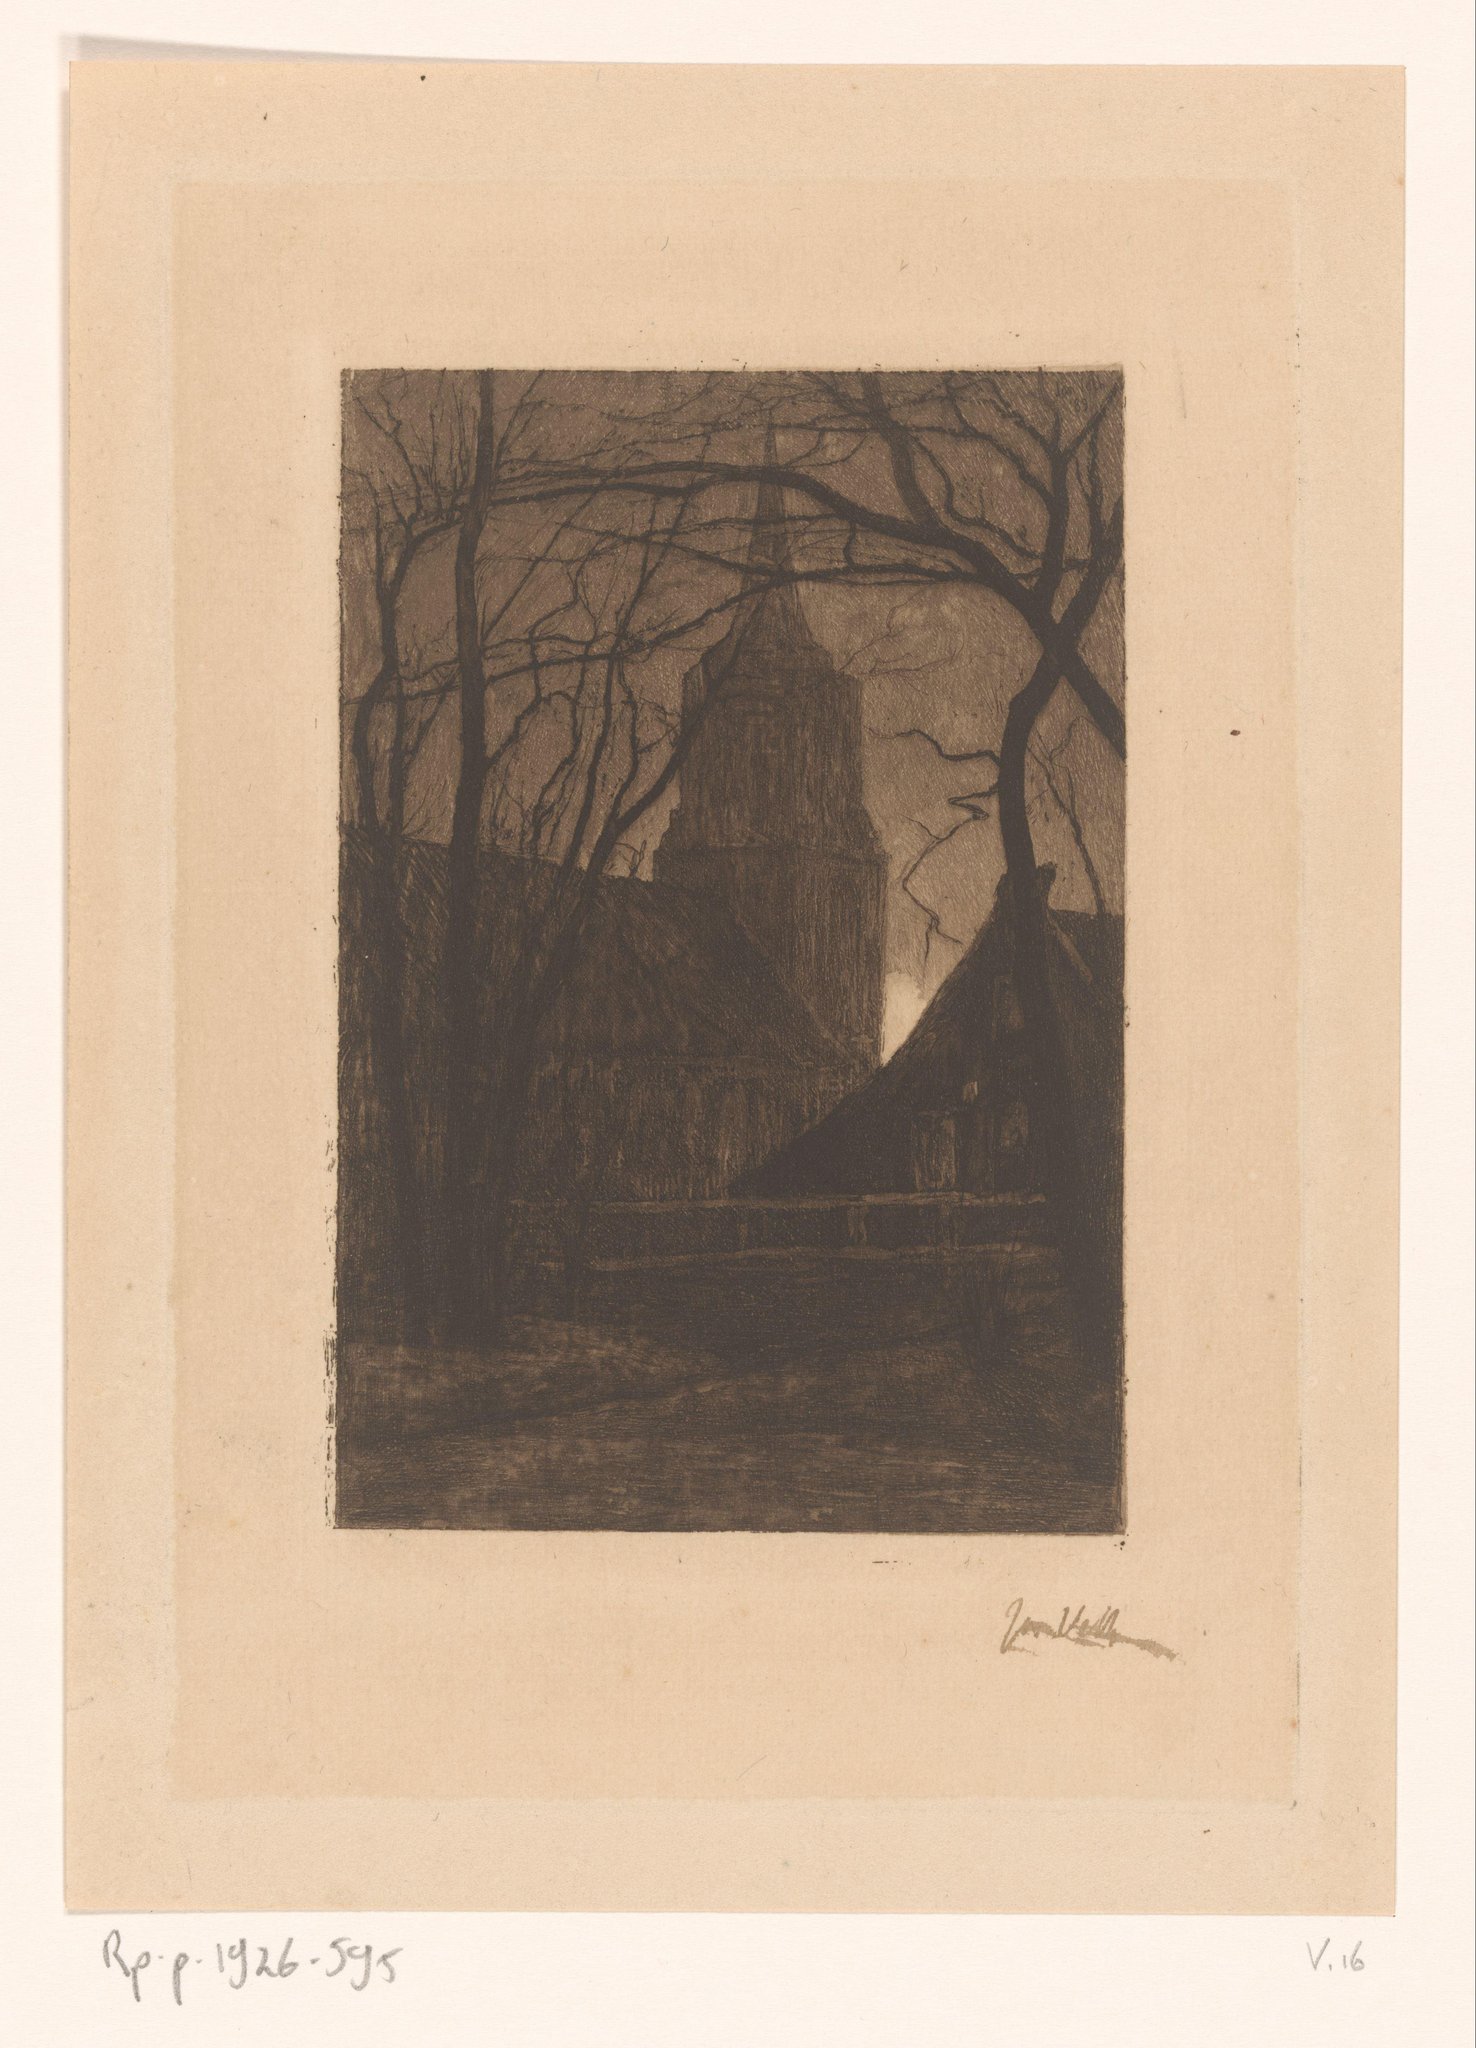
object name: print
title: Kerk te Laren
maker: jan veth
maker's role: designer, draughtsman, painter, print maker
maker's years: 1864-1925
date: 1886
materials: paper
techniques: drypoint, etching, intaglio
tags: church (exterior)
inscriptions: collector's mark: Lugt 2228